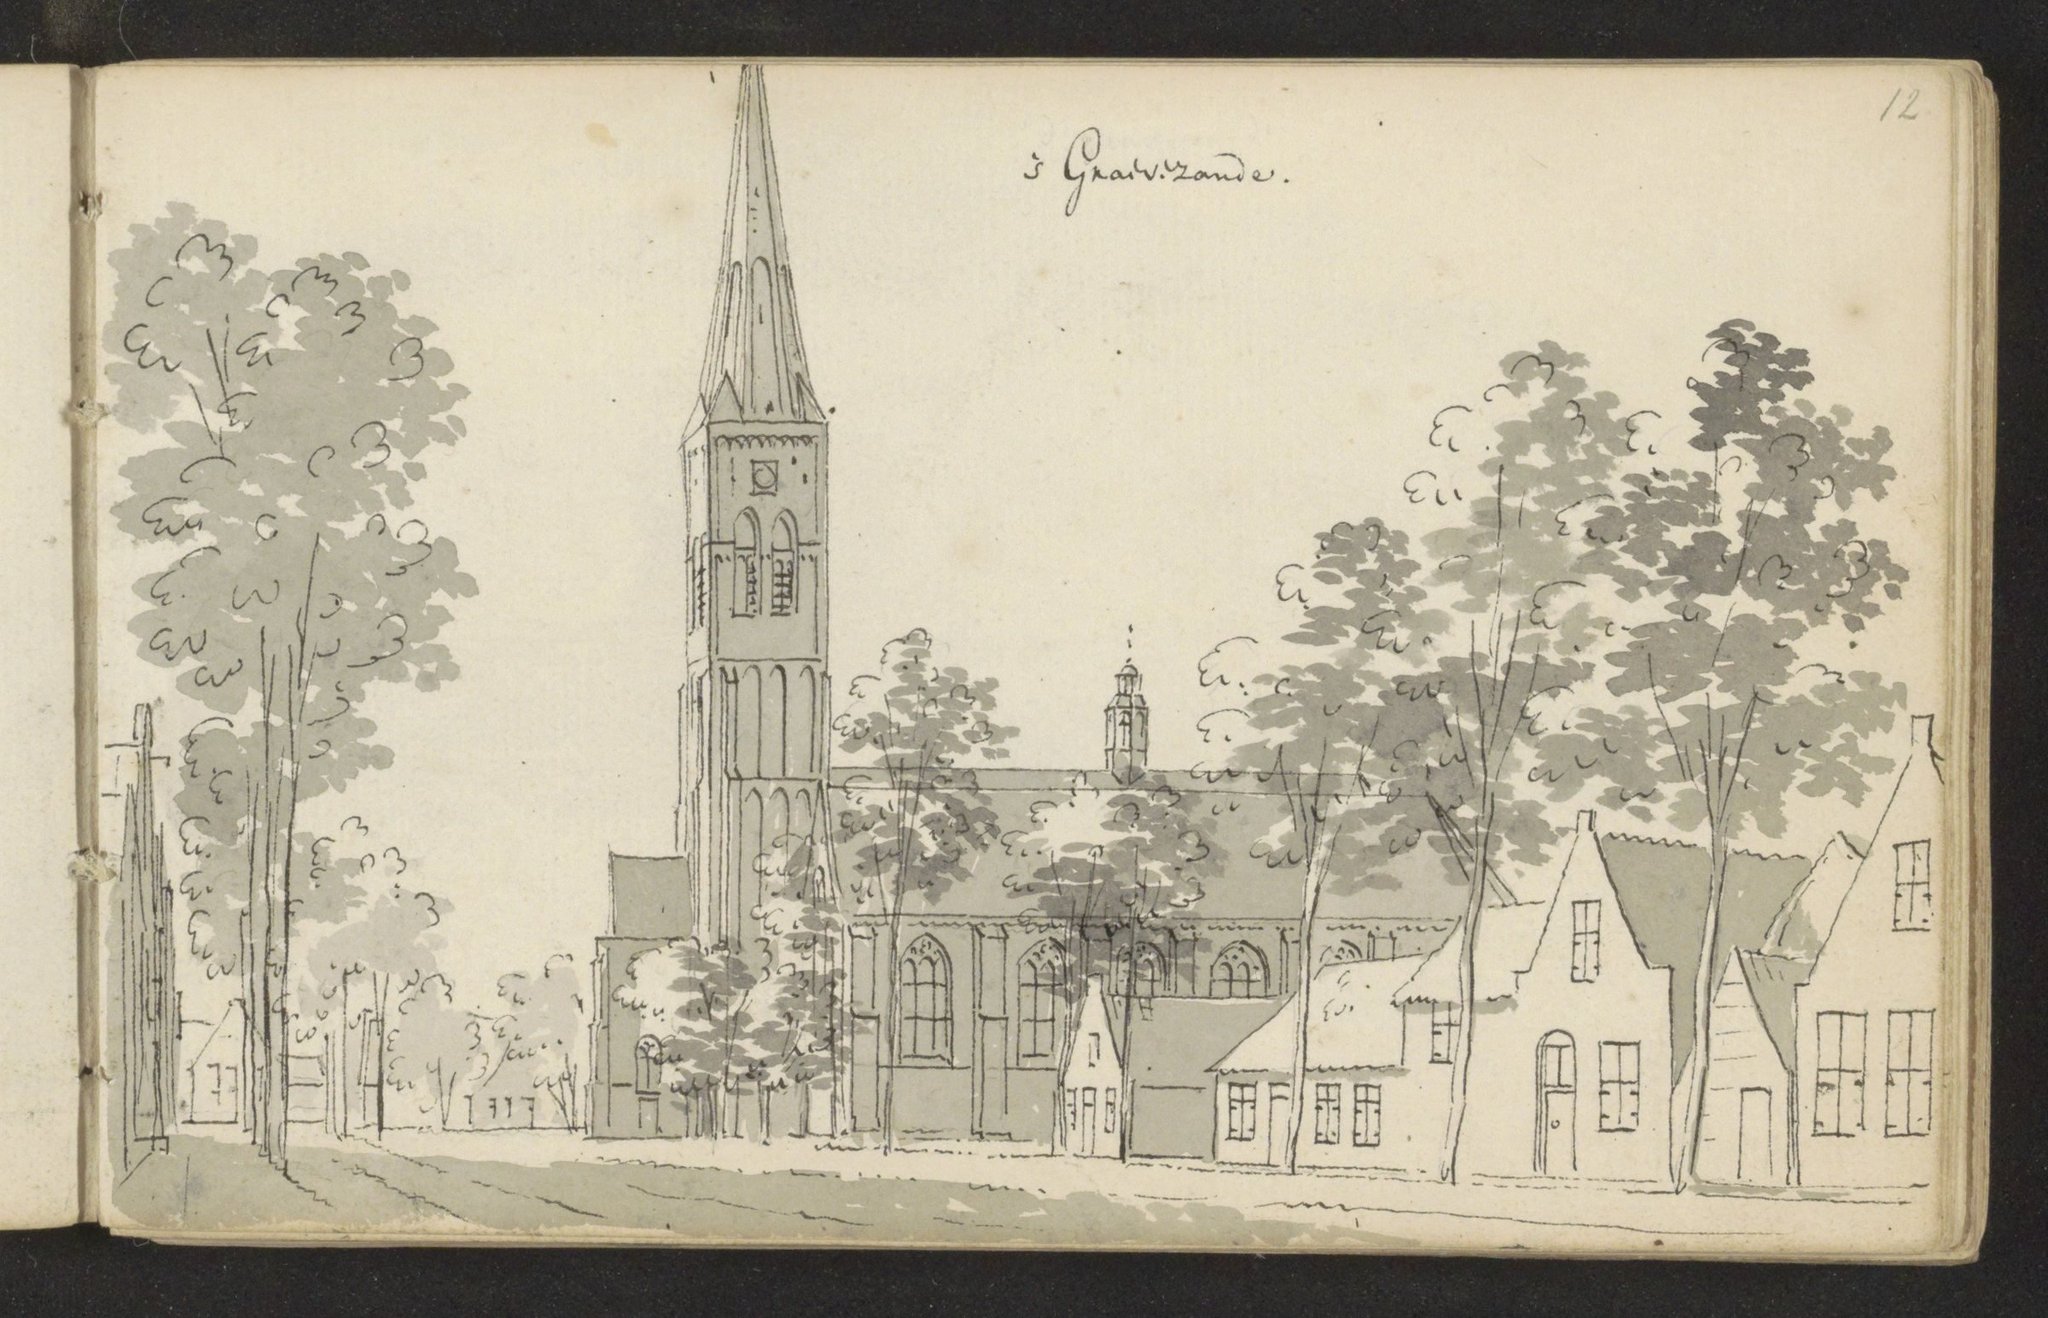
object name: sketchbook leaf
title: Dorpsgezicht met kerk te 's-Gravenzande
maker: abraham de haen (ii)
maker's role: draughtsman, print maker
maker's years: 1707-1748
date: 1731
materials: ink, paper, pencil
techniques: brush, pen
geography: s-gravenzande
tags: public road in village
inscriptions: annotation: ‘'s-Graevezande.’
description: Blad 12 recto uit een schetsboek met 78 bladen.